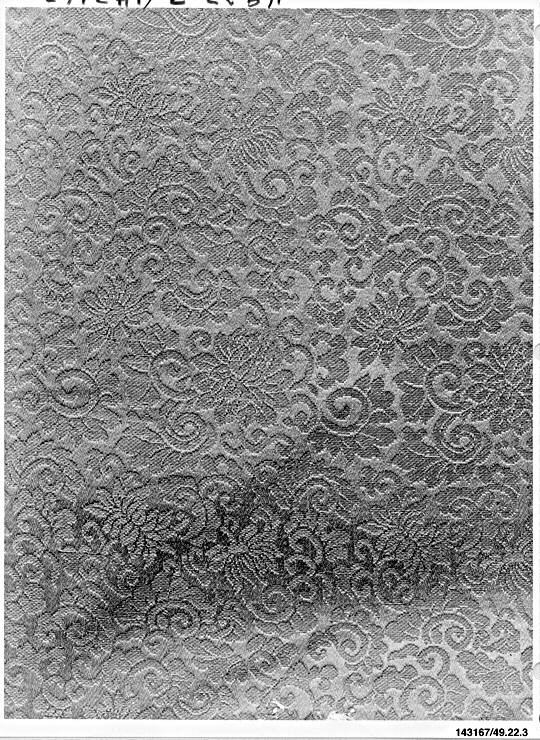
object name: piece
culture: chinese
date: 1901-2000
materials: metal thread, silk